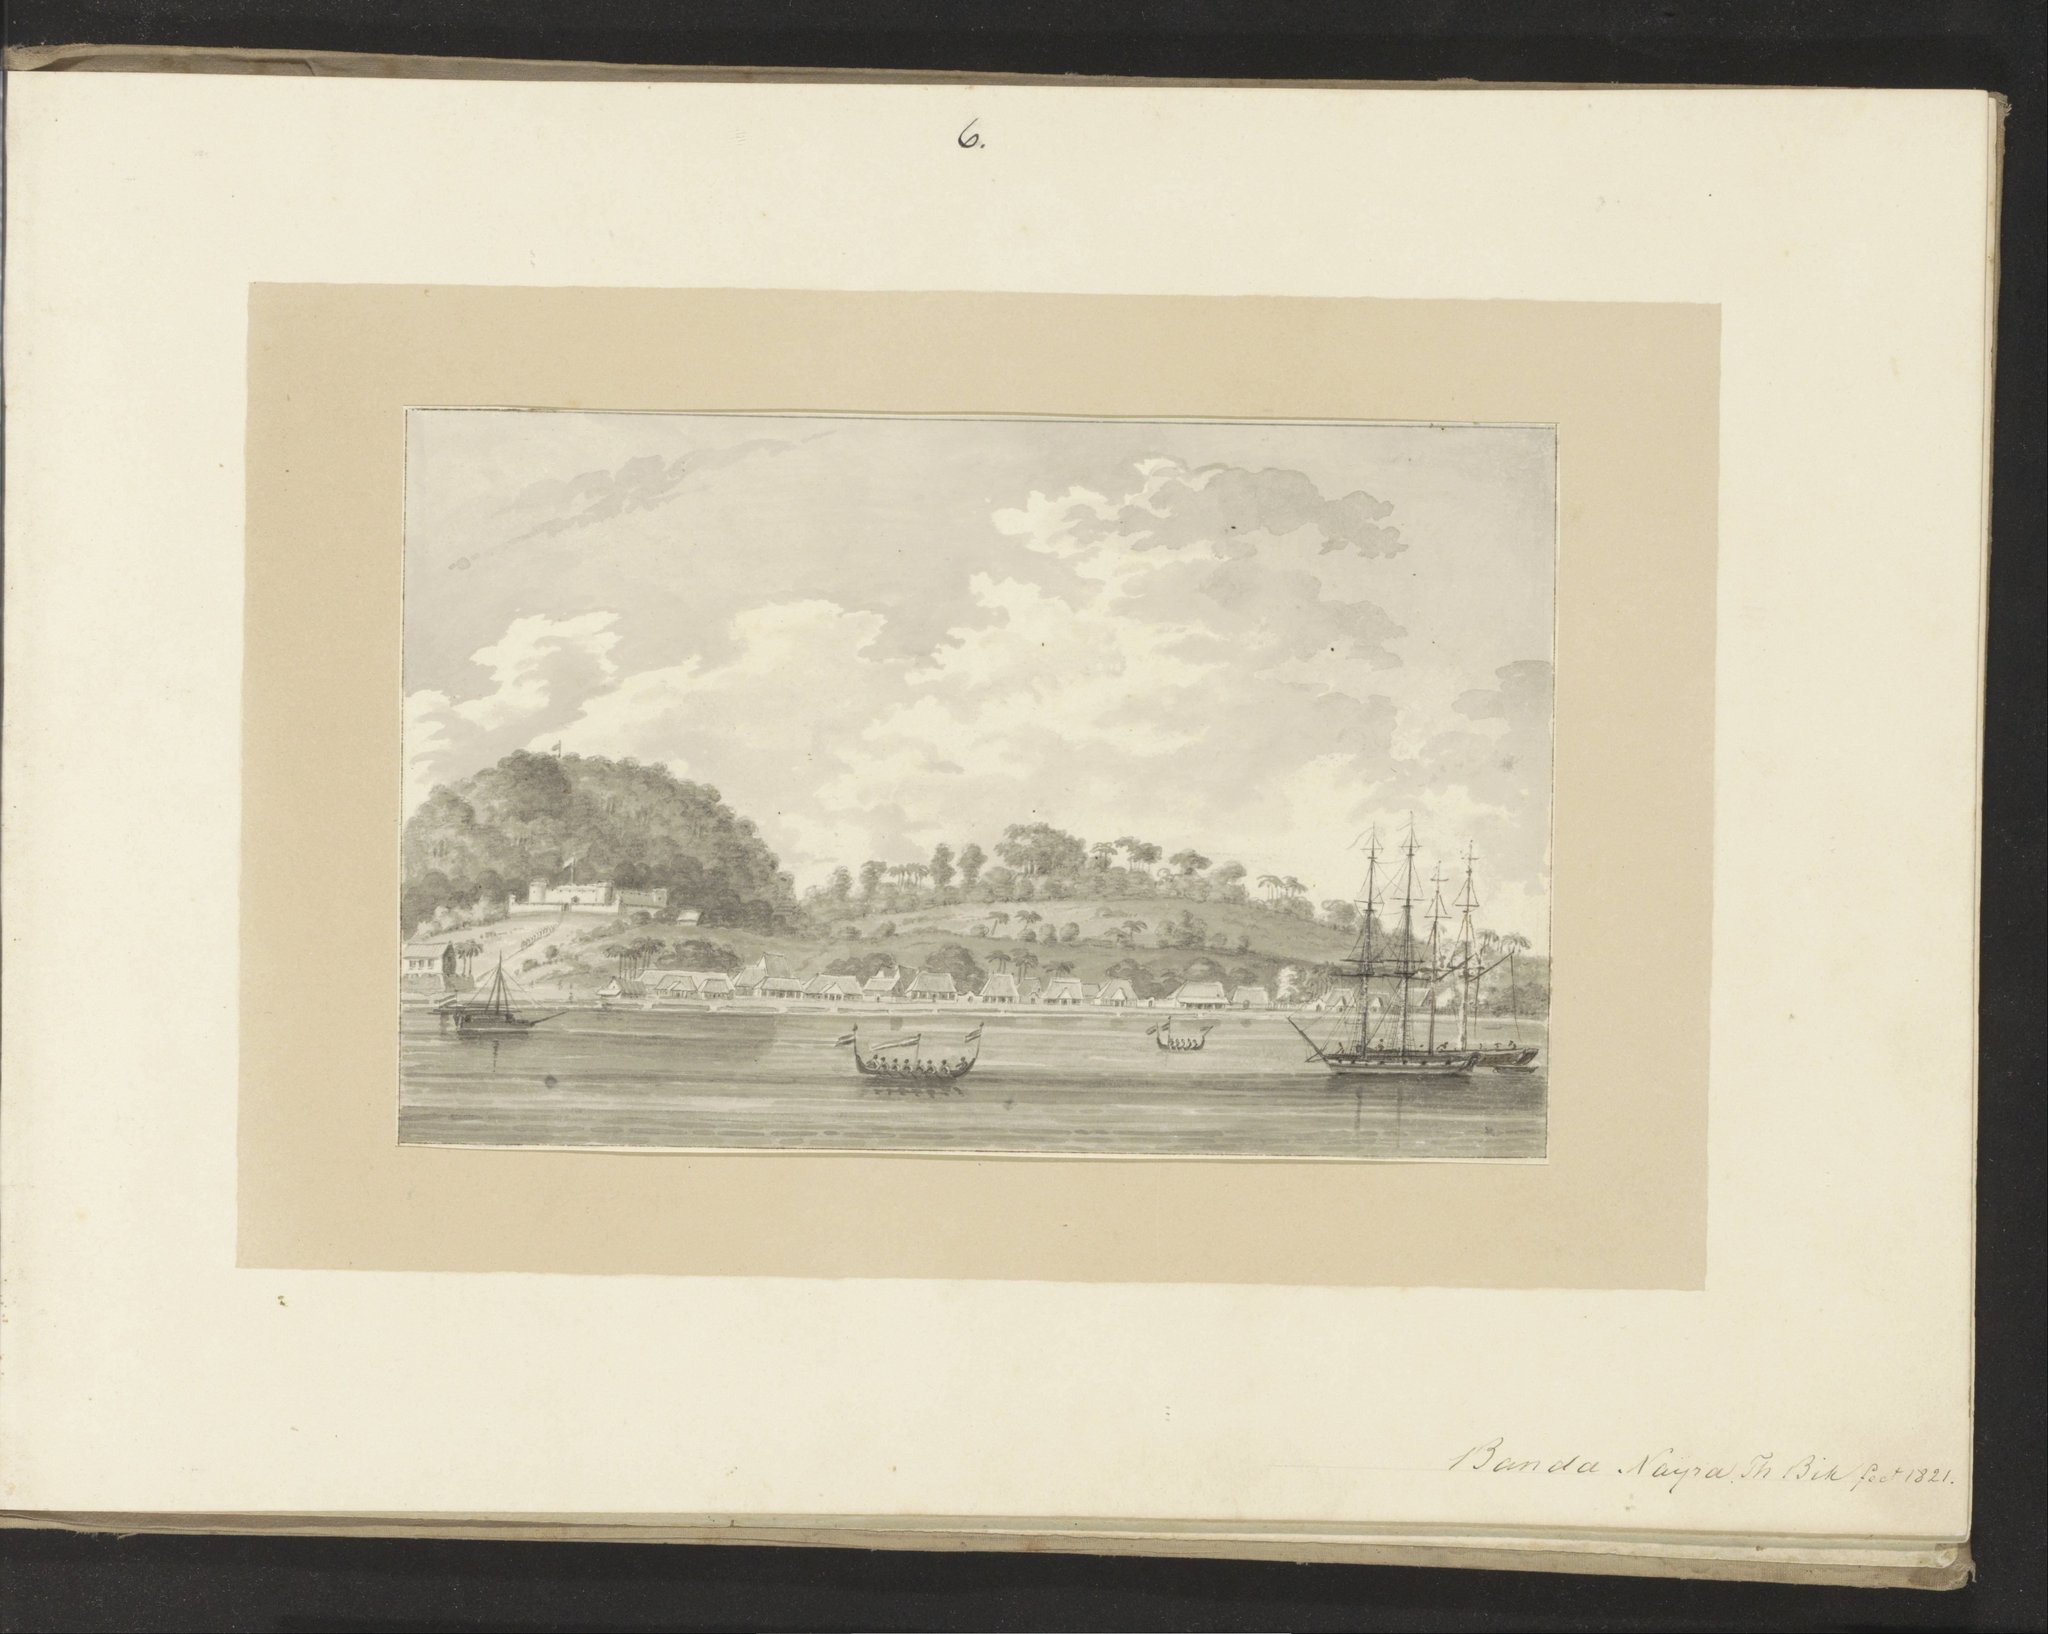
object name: album leaf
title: Gezicht op Banda Neira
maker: jannes theodorus bik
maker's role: draughtsman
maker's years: 1796-1872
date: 1821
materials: chalk, ink, paper, pencil, watercolor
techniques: brush, pen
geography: banda neira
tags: prospect of village, silhouette of village, island, sailing-ship, sailing-boat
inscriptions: annotation: ‘Banda Nayra’, signature and date: ‘Th. Bik fect 1821.’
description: Blad 6 uit een album met 14 tekeningen en een prent.